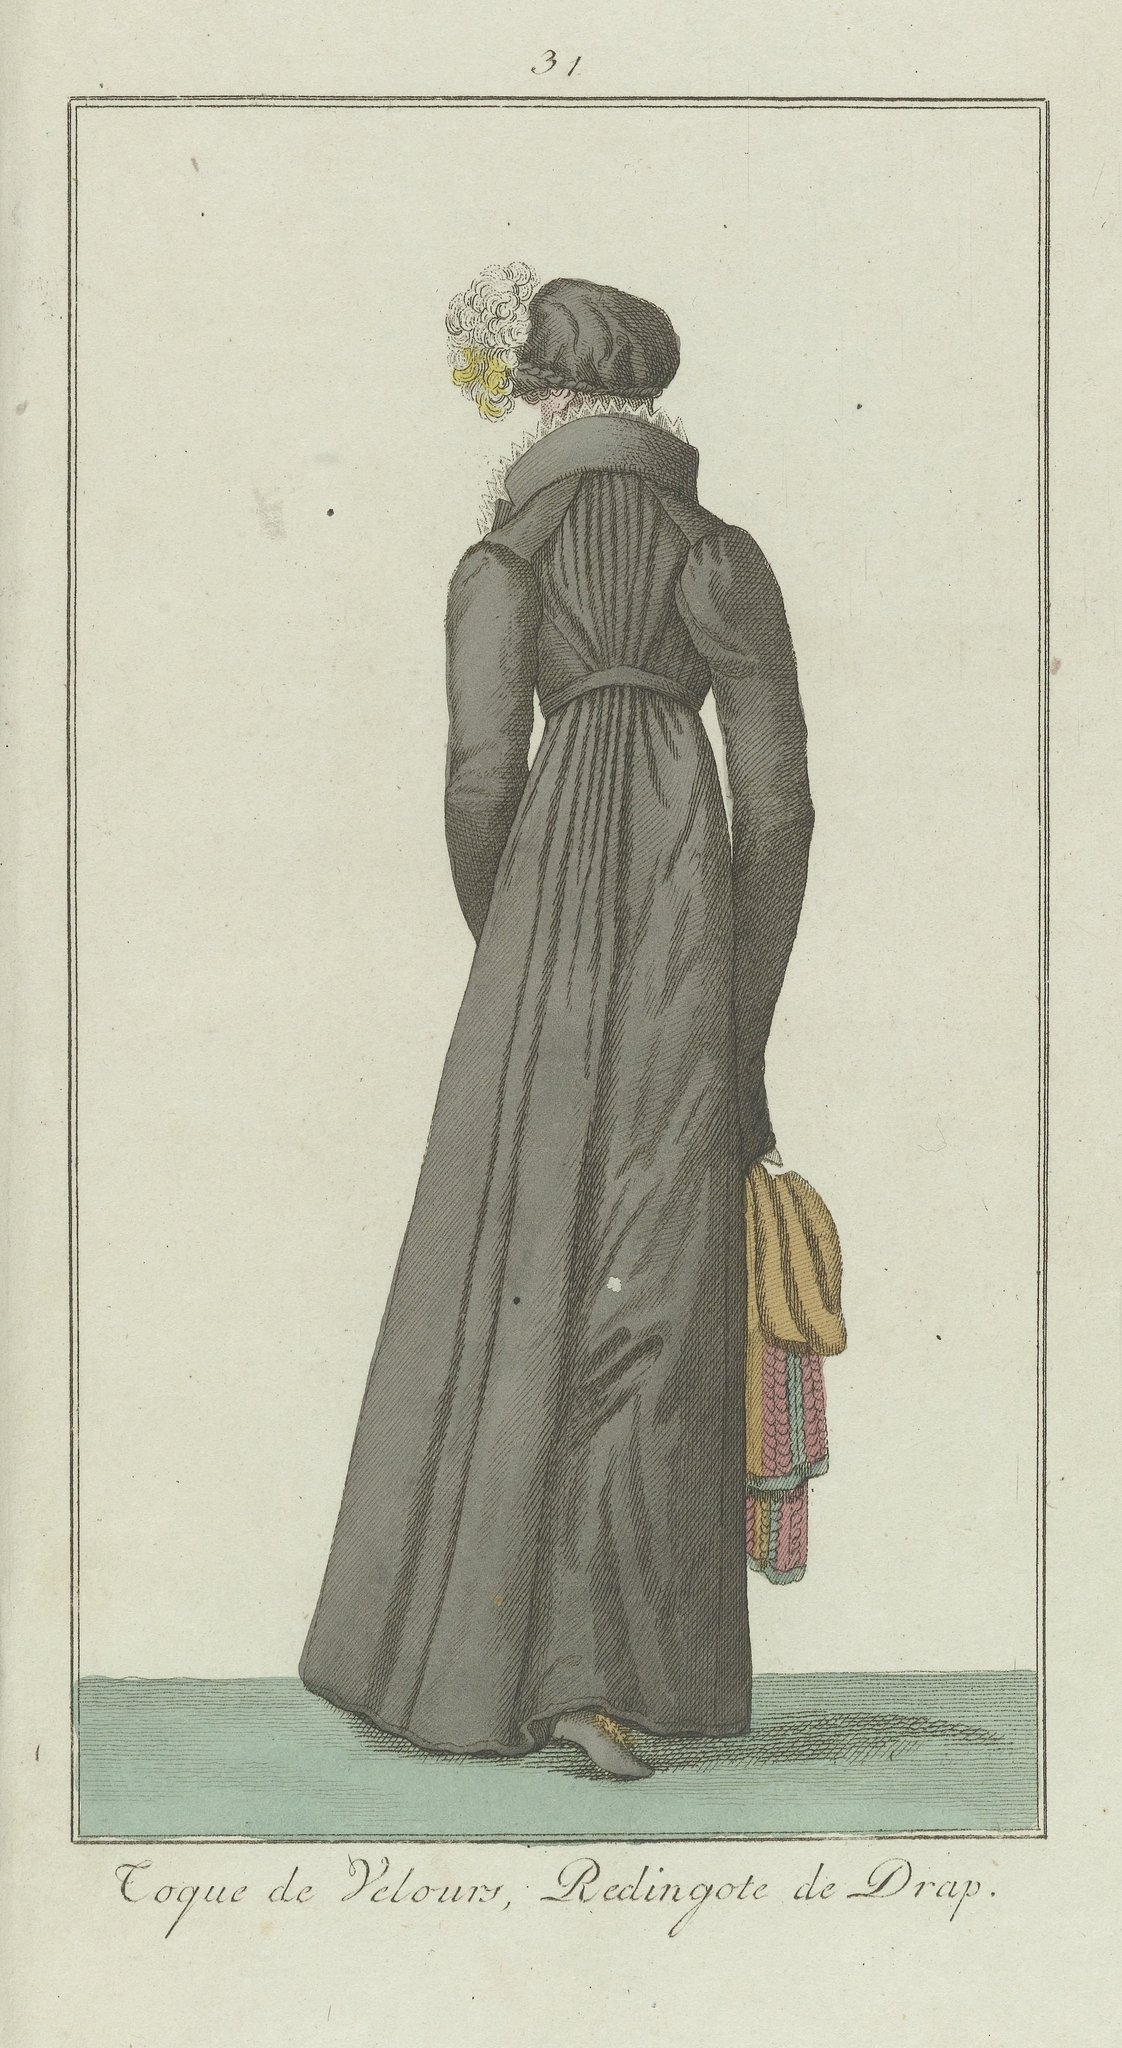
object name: magazine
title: Elegantia, of tijdschrift van mode, luxe en smaak voor dames, December 1807, No. 31 : Toque de Velours...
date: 1807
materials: paper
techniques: engraving, hand coloring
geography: amsterdam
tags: head-gear: toque (+ women's clothes), clothing for the upper part of the body (shawl) (+ women's clothes), dress, gown: redingote (+ women's clothes), fashion plates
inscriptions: caption: ‘Toque de Velours, Redingote de Drap.’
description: Volgens de begeleidende tekst (p. 392): Redingote van zwart laken, met geplooide rug. Zwart fluwelen toque met witte gefriseerde pluimen. Prent uit het modetijdschrift Elegantia, of tijdschrift van mode, luxe en smaak voor dames 1807-1814 (onderbroken door de periode 1811-1813).